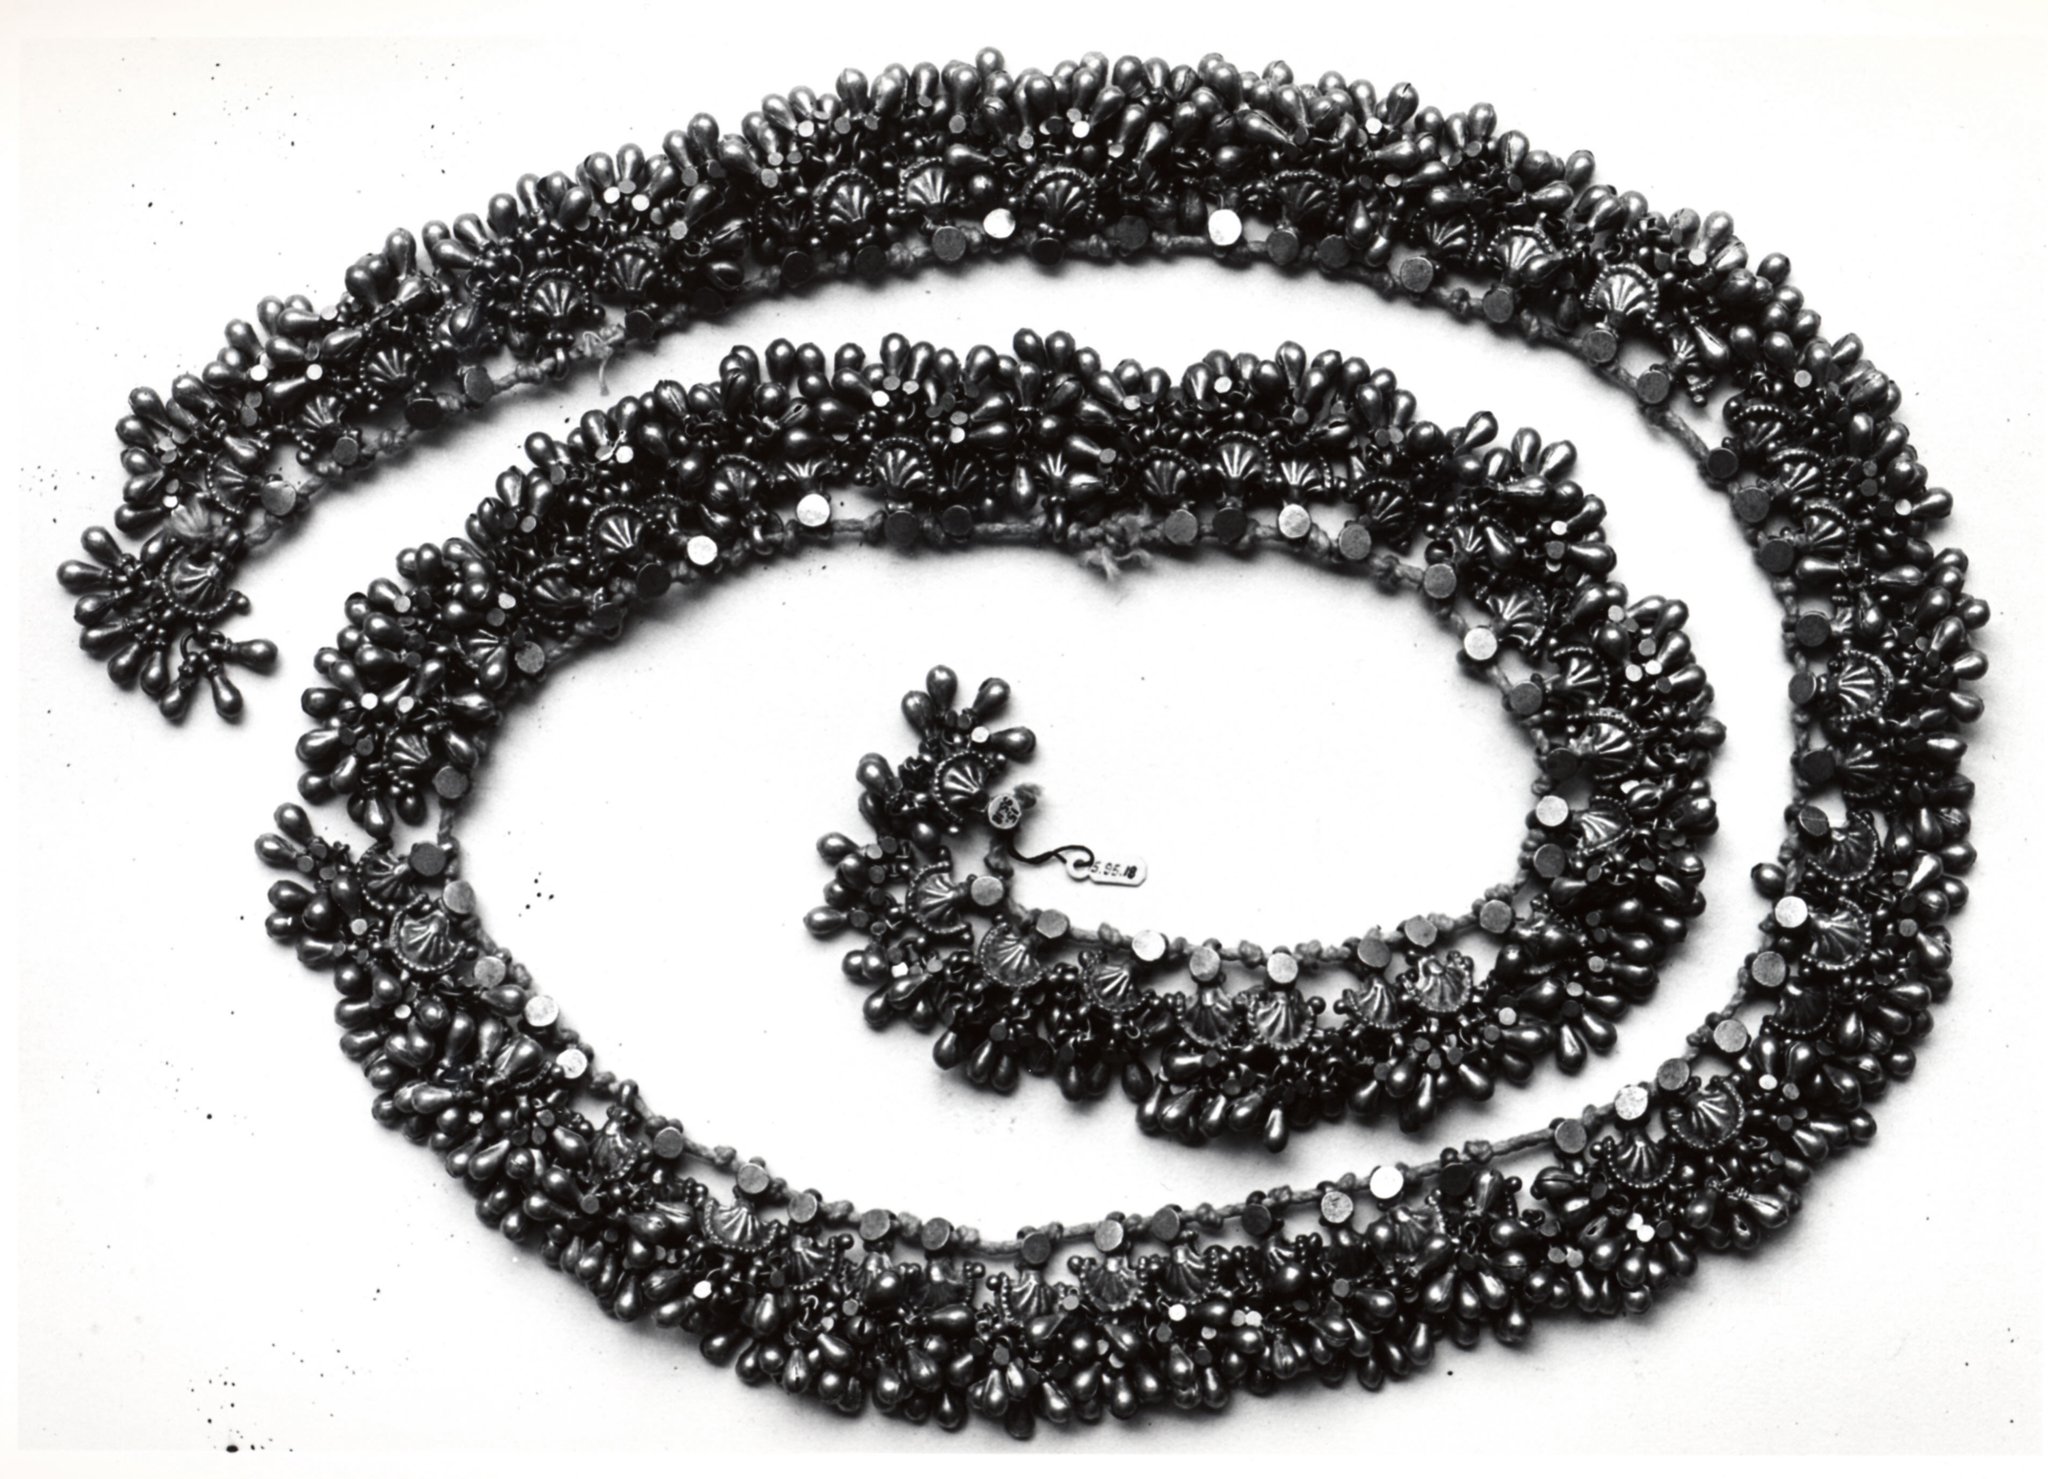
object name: necklace or girdle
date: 1701-1900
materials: silver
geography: india